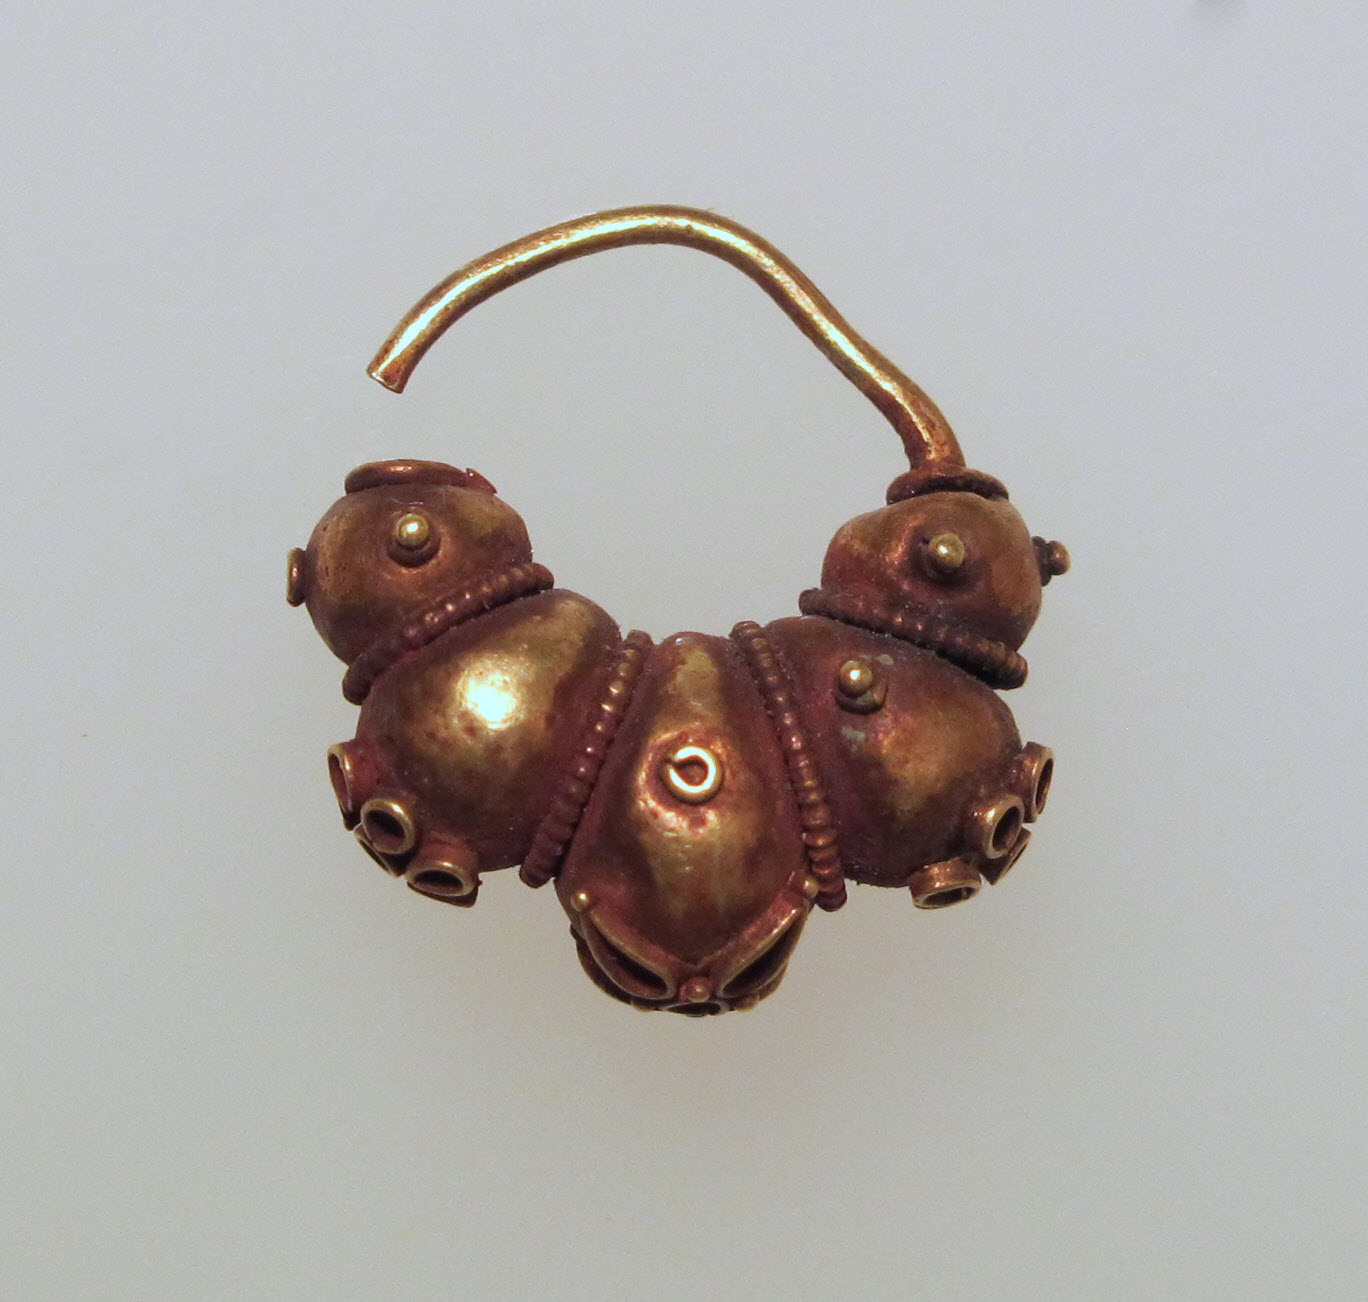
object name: earring with lobe and rosette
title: Electrum earring with lobes and rosettes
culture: cypriot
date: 600-501 BCE